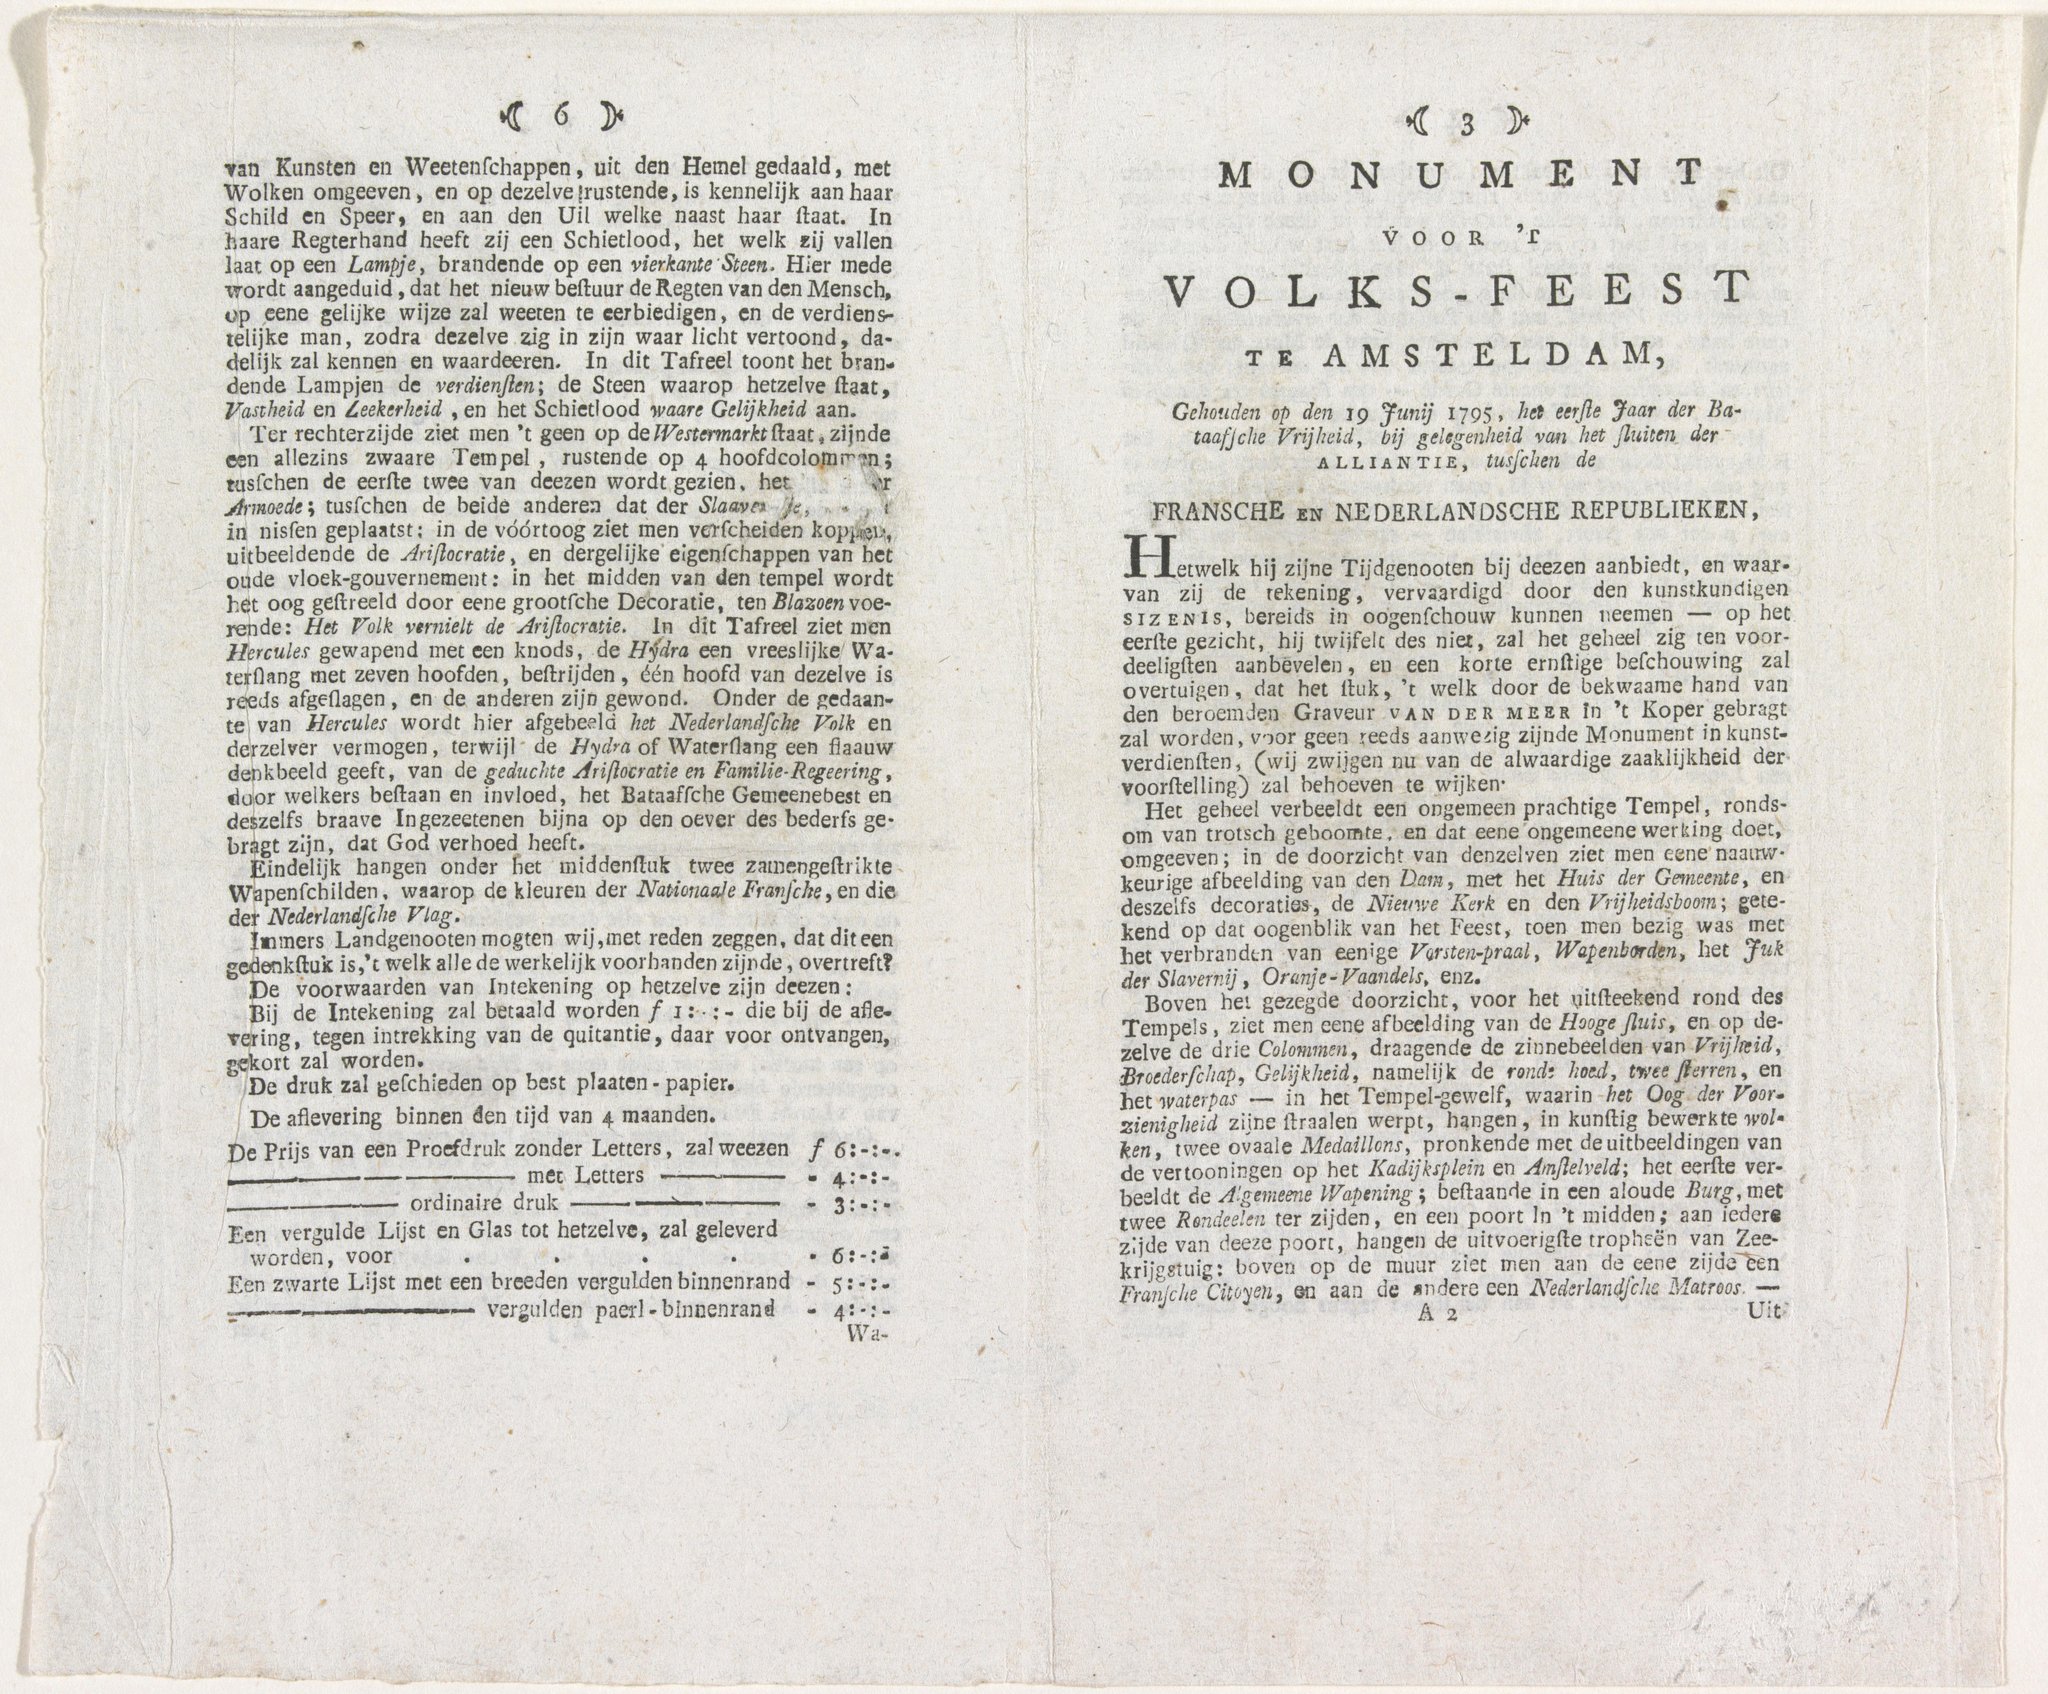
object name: uitgeversprospectus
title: Monument voor 't Volks-feest te Amsterdam (...)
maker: dirk meland langeveld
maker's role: publisher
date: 1795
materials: paper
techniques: letterpress printing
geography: amsterdam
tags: amsterdam, alliance with france (1795)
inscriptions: collector's mark: Lugt 2228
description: Uitgeversprospectus voor de prent van het monument in de vorm van een tempel waarin zijn afgebeeld alle decoraties opgericht bij het Alliantiefeest te Amsterdam op 19 juni 1795. Opengevouwen tekstblad bedrukt op vier zijden genummerd 3-6. Met een beschrijving en uitleg van de voorstelling en een overzicht van de prijzen van verschillende drukken.